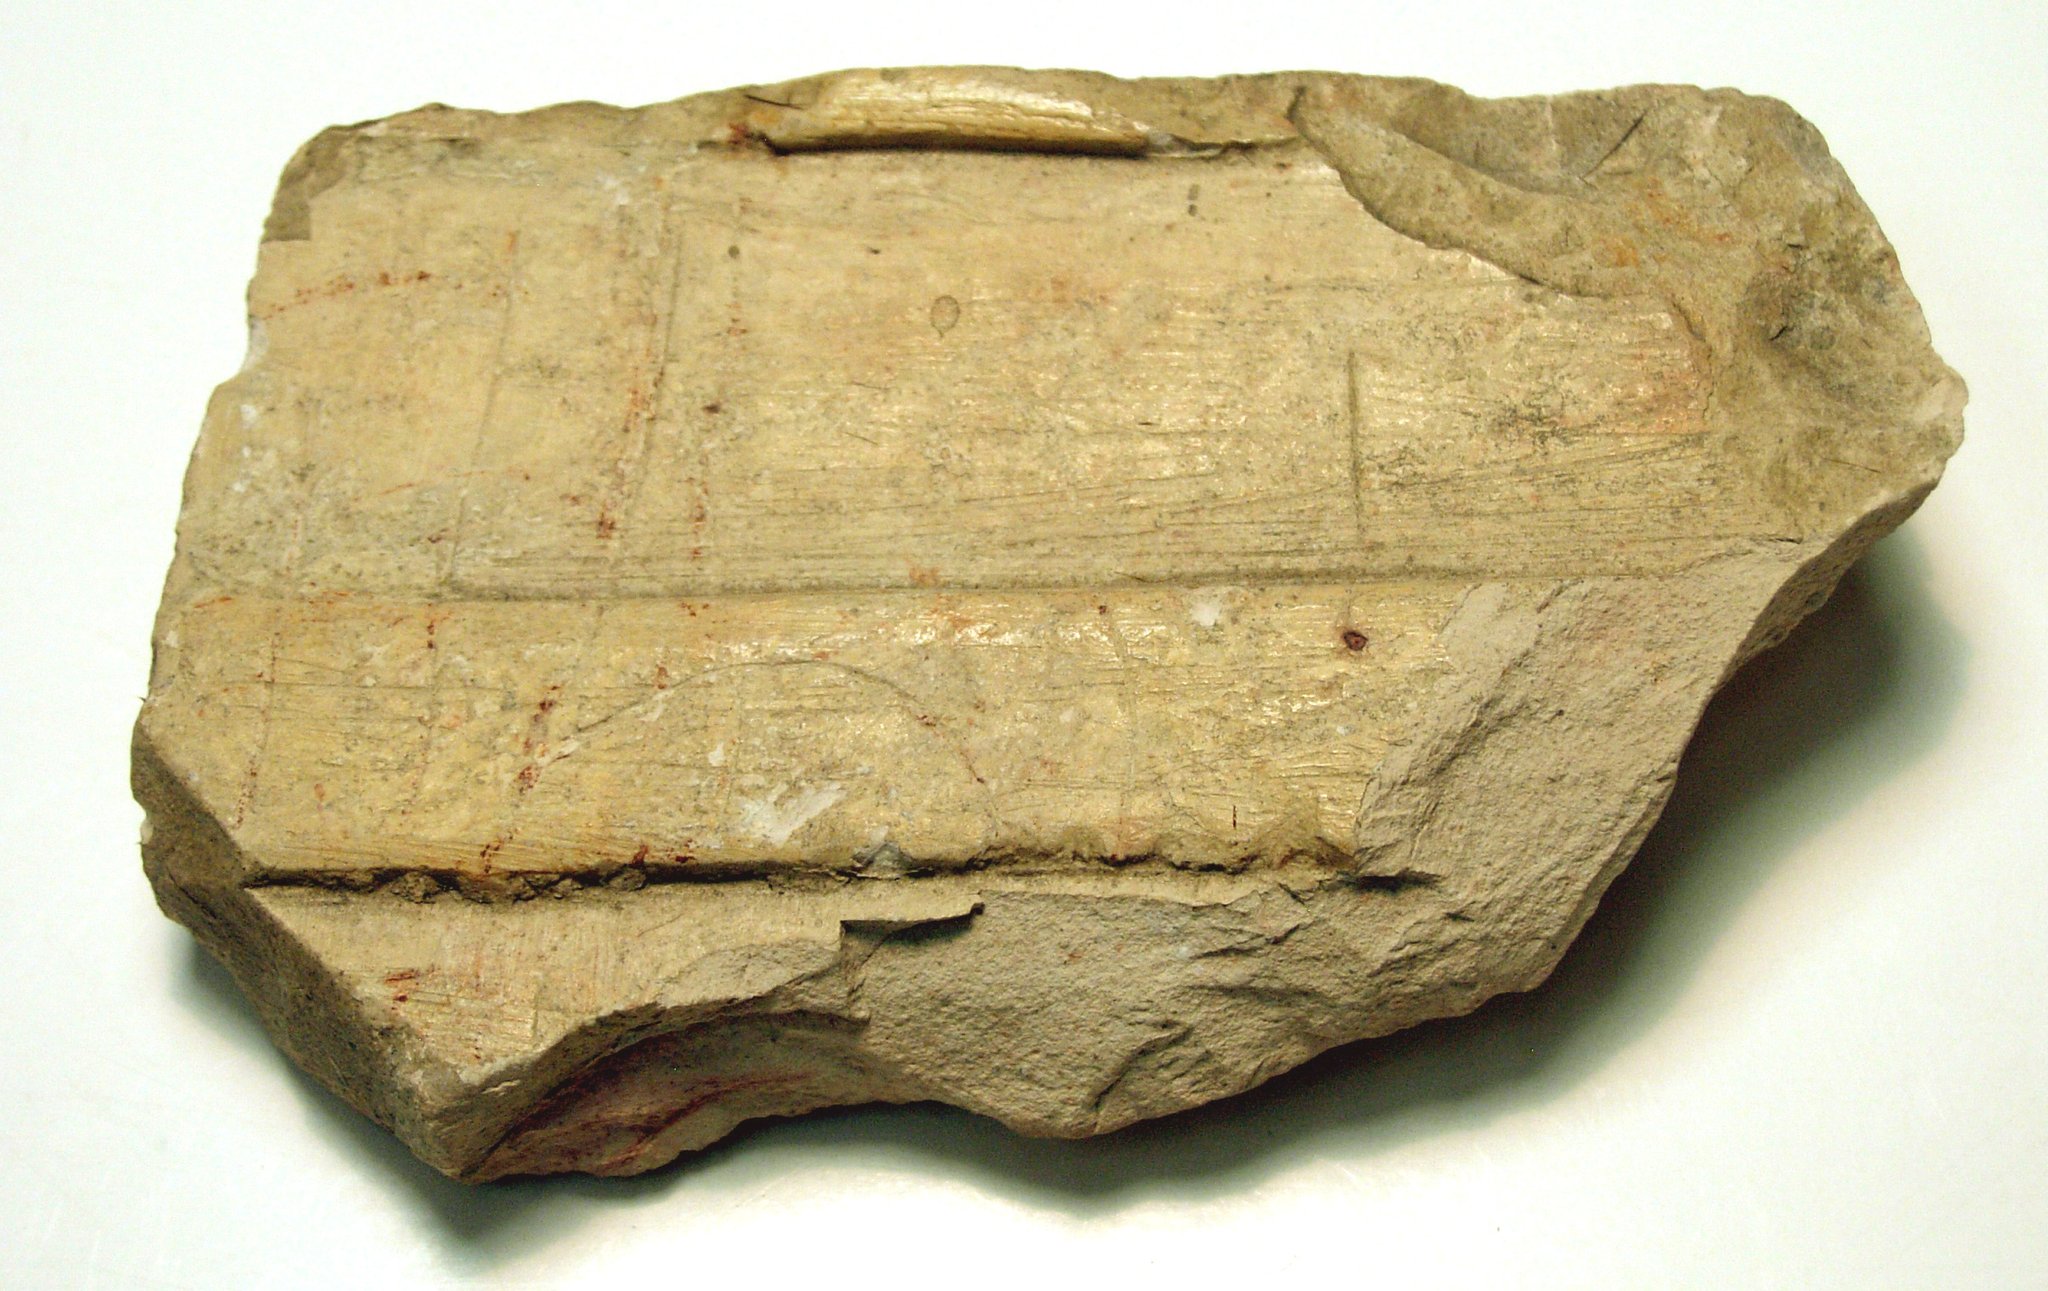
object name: relief, tomb of nespekashuty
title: Raised relief fragment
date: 664-610 BCE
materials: limestone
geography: egypt